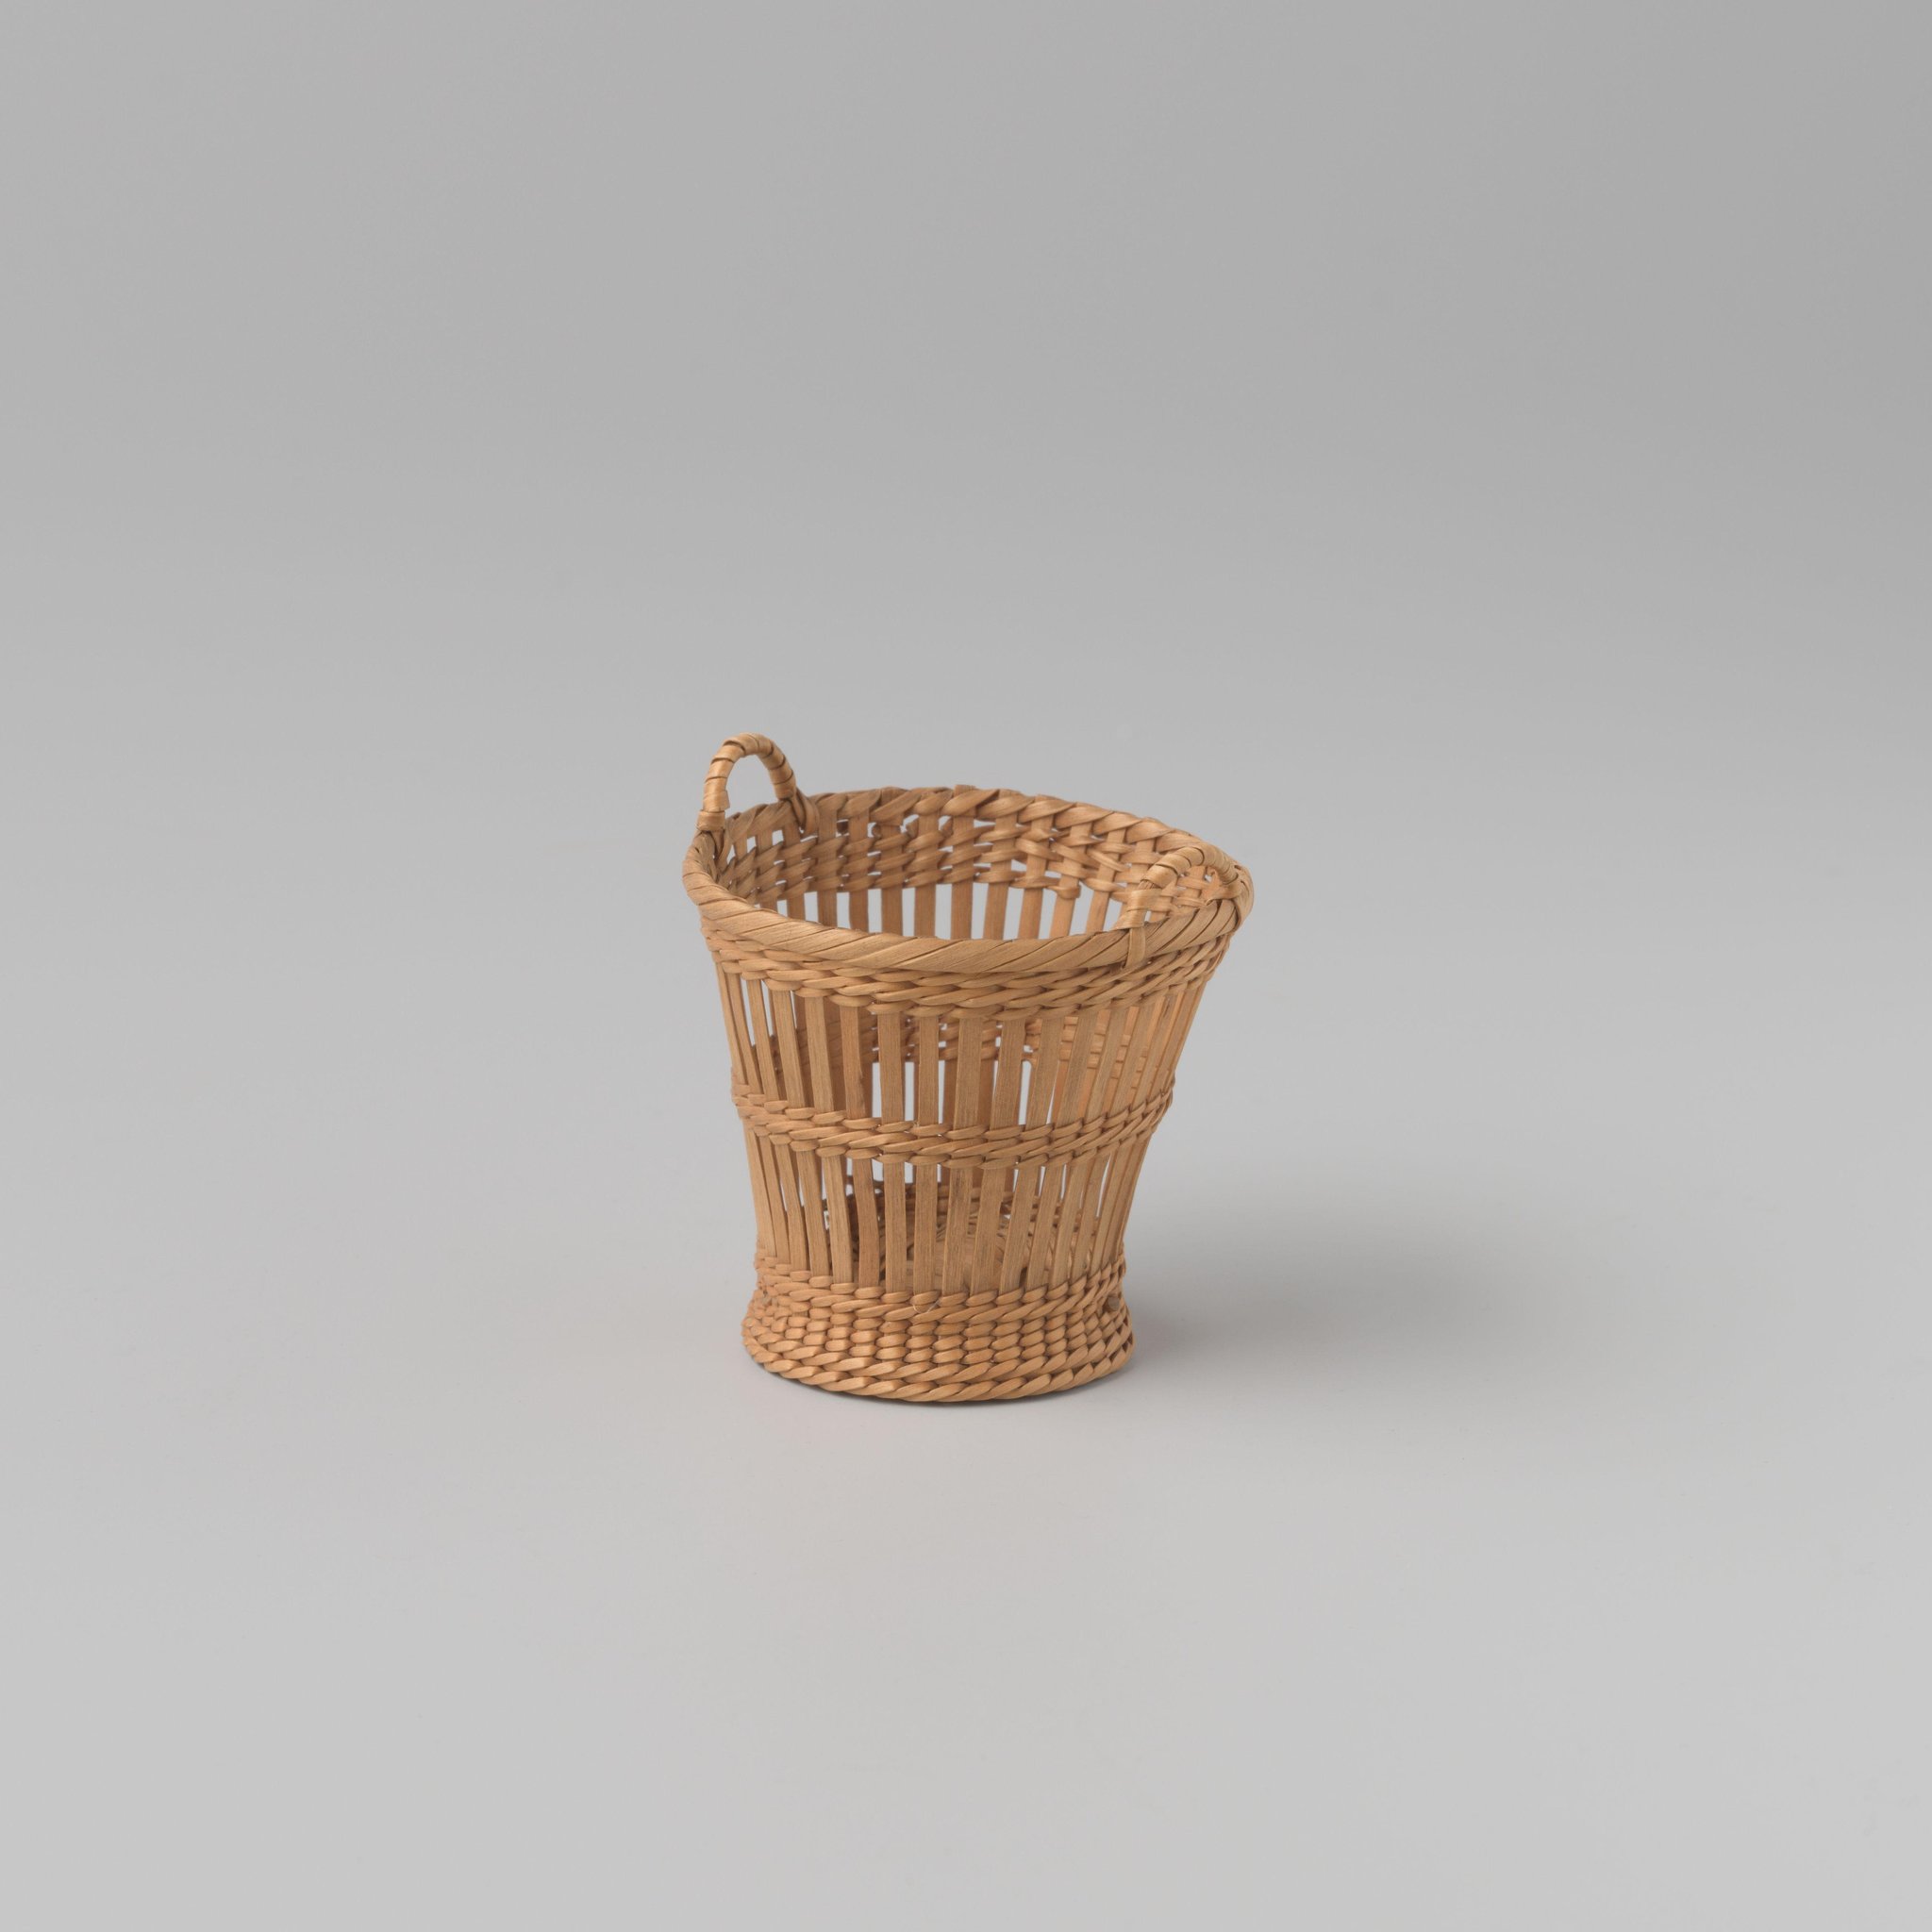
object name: sewing basket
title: Naaimand vervaardigd van gespleten wilgenteen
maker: Anonymous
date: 1676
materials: plant material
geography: halle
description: Naaimand, rond, van gespleten wilgenteen, met twee handvatten, fijnscheenwerk.